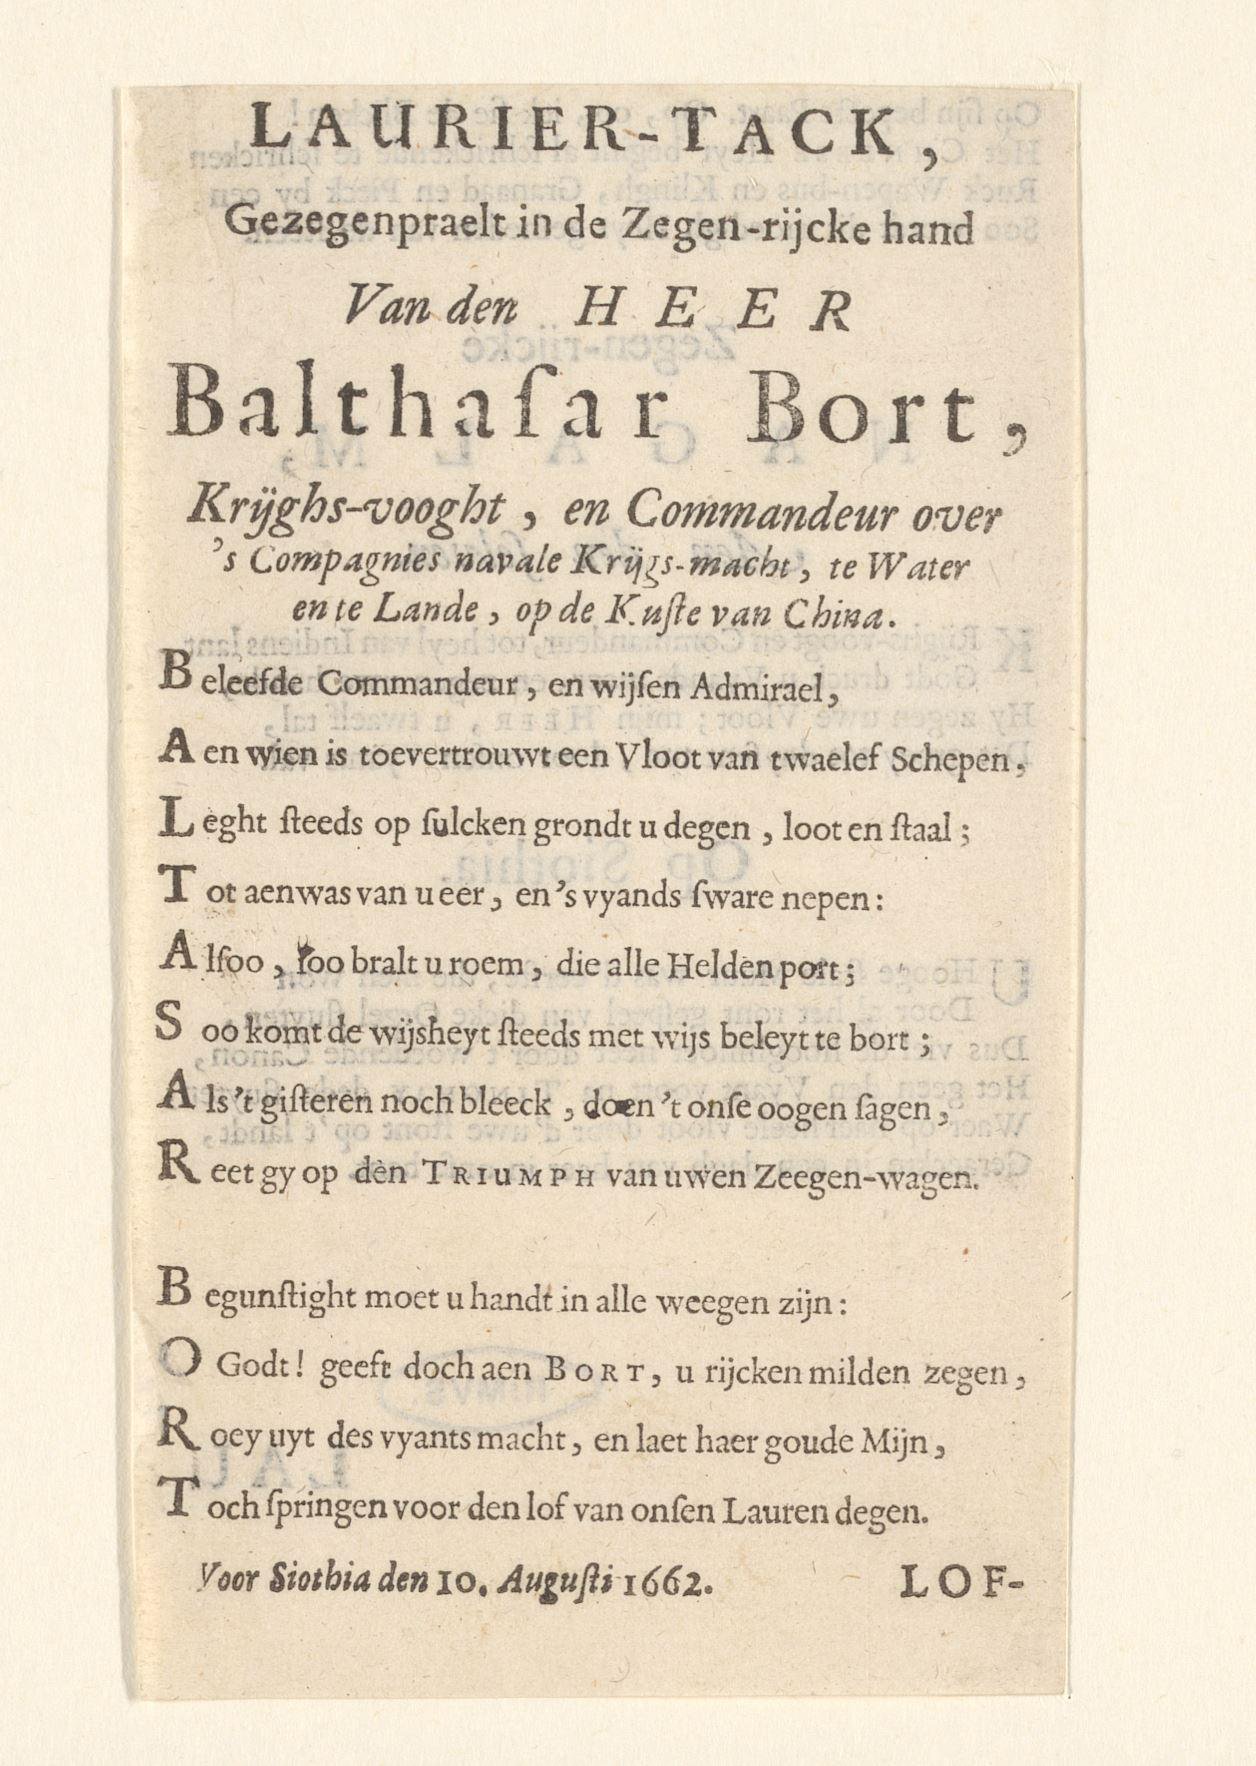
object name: text sheet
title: Vers ter ere van Bathasar Bort, 1662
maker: Anonymous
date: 1662-1670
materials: paper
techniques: letterpress printing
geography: northern netherlands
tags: japan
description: Acrostichon ter ere van Bathasar Bort, 10 augustus 1662. Tekstblad aan beide zijden bedrukt. In verband met de expeditie van de VOC van 1662-1668 onder leiding van Balthasar Bort tegen de Chinese krijgsheer Coxinga.